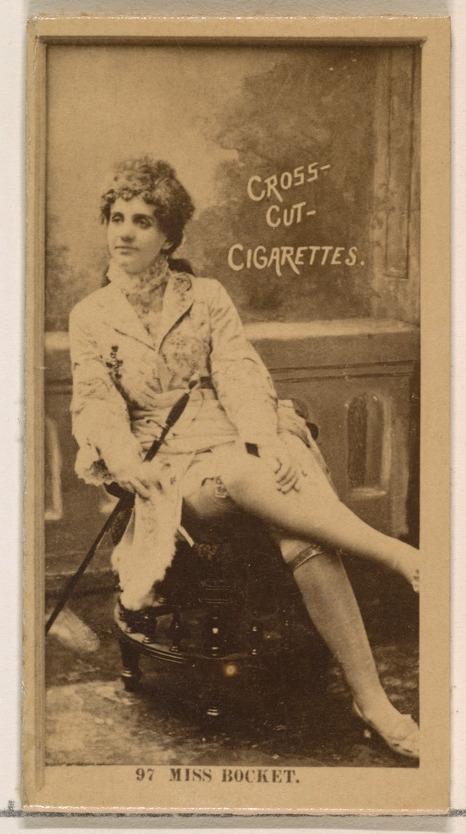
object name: print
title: Card Number 97, Miss Bocket, from the Actors and Actresses series (N145-2) issued by Duke Sons & Co. to promote Cross Cut Cigarettes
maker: w. duke, sons & co.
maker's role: publisher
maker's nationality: american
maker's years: 1870-1920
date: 1880-1889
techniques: albumen silver print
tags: portraits,women,actresses